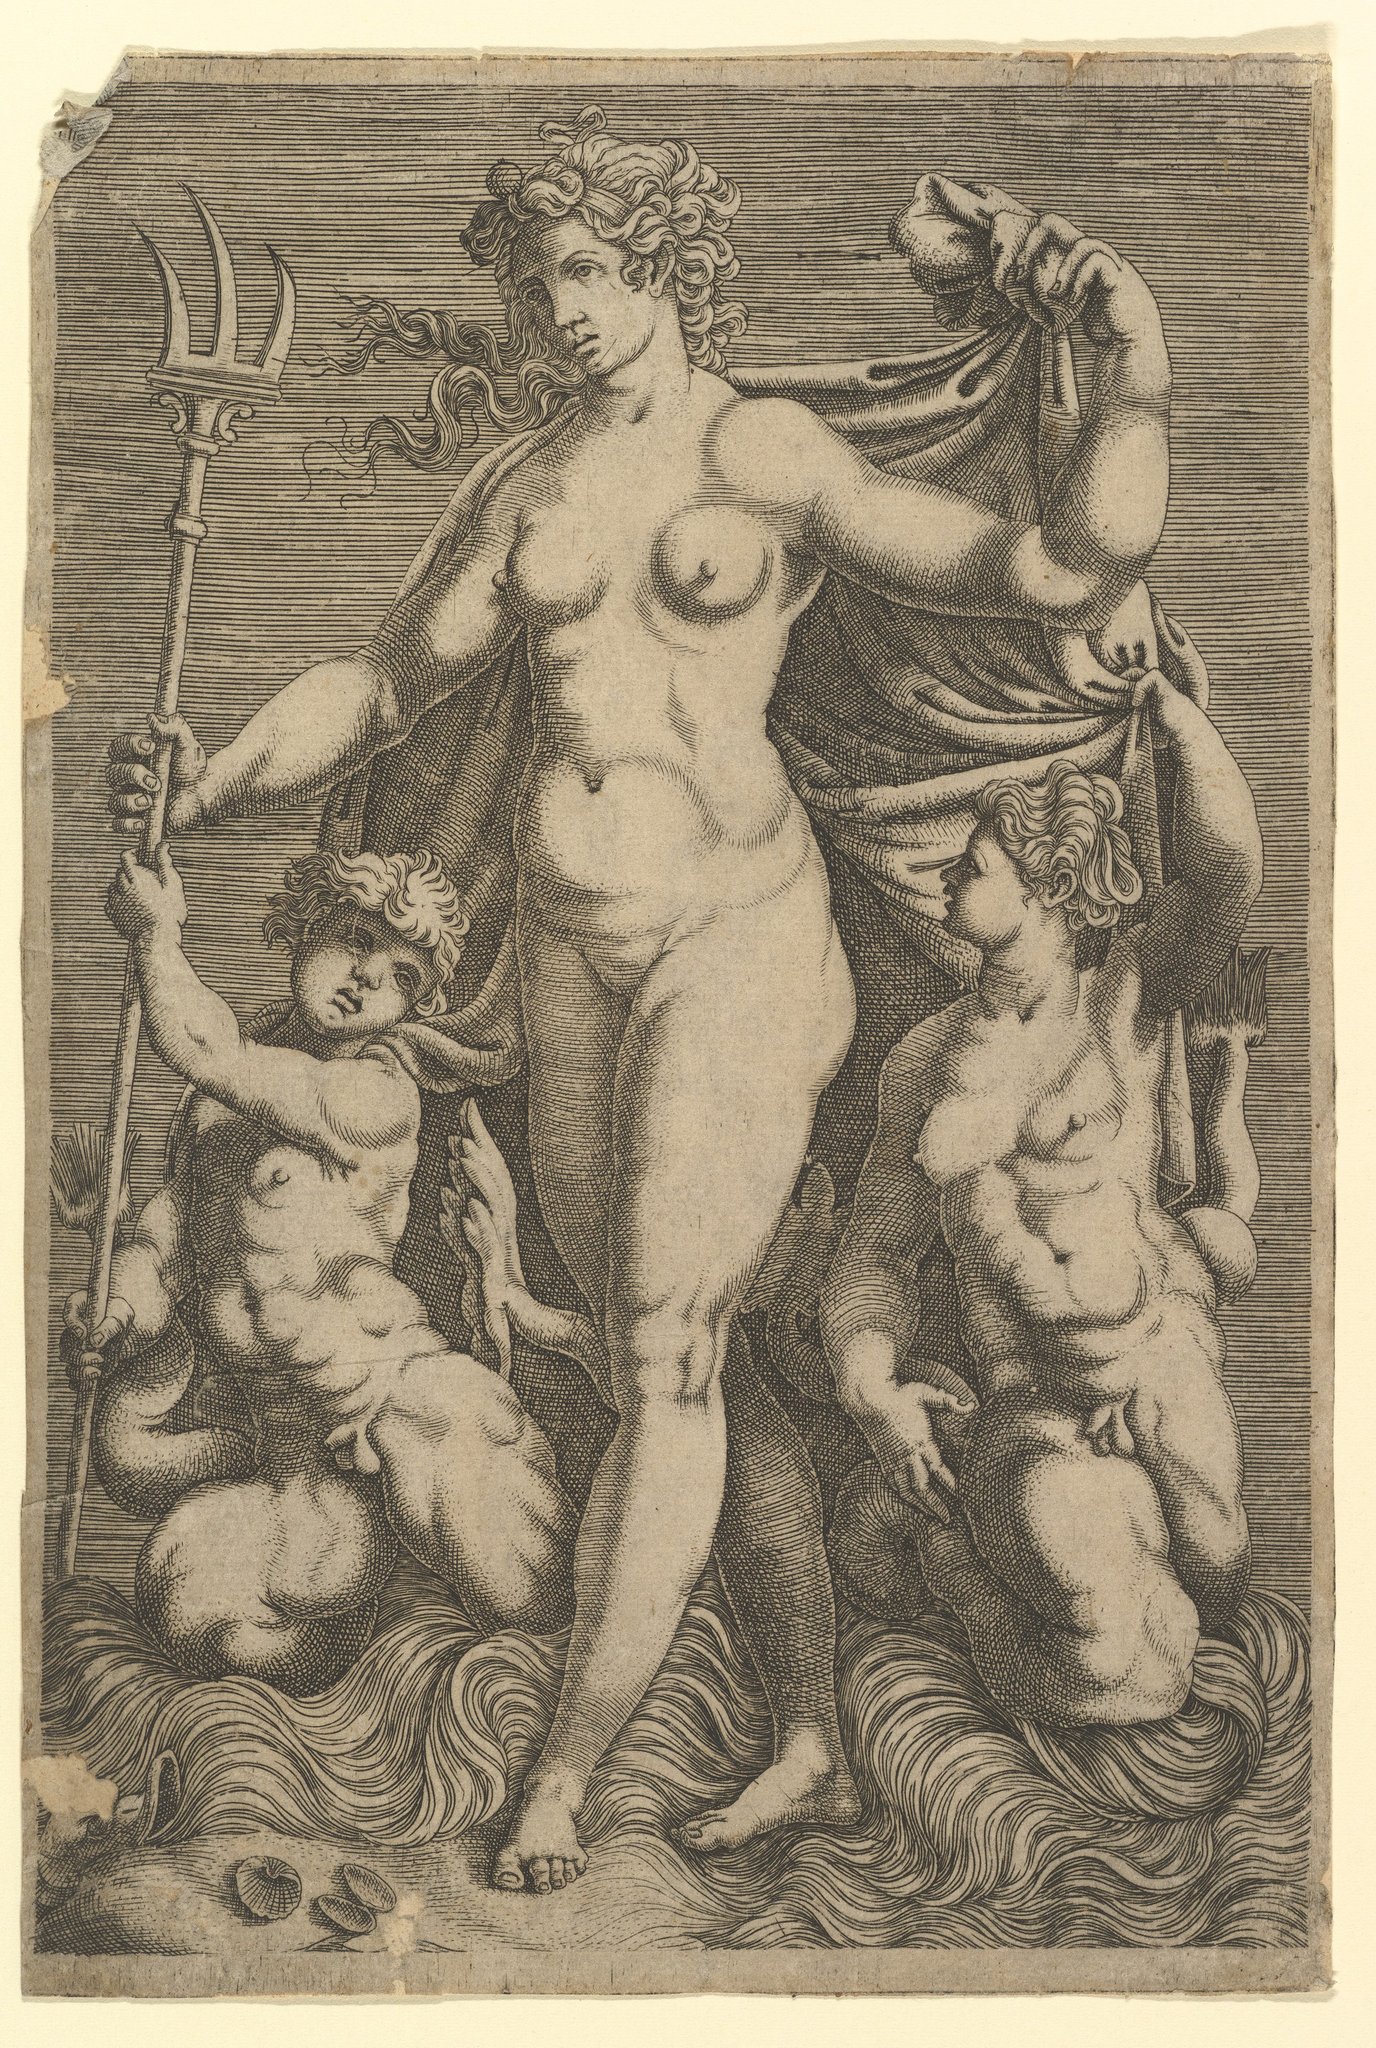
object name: print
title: Thetis Standing with Two Tritons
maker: anonymous, italian?, 16th century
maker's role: artist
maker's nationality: italian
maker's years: 1500-1600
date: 1550-1600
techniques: engraving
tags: triton,goddess